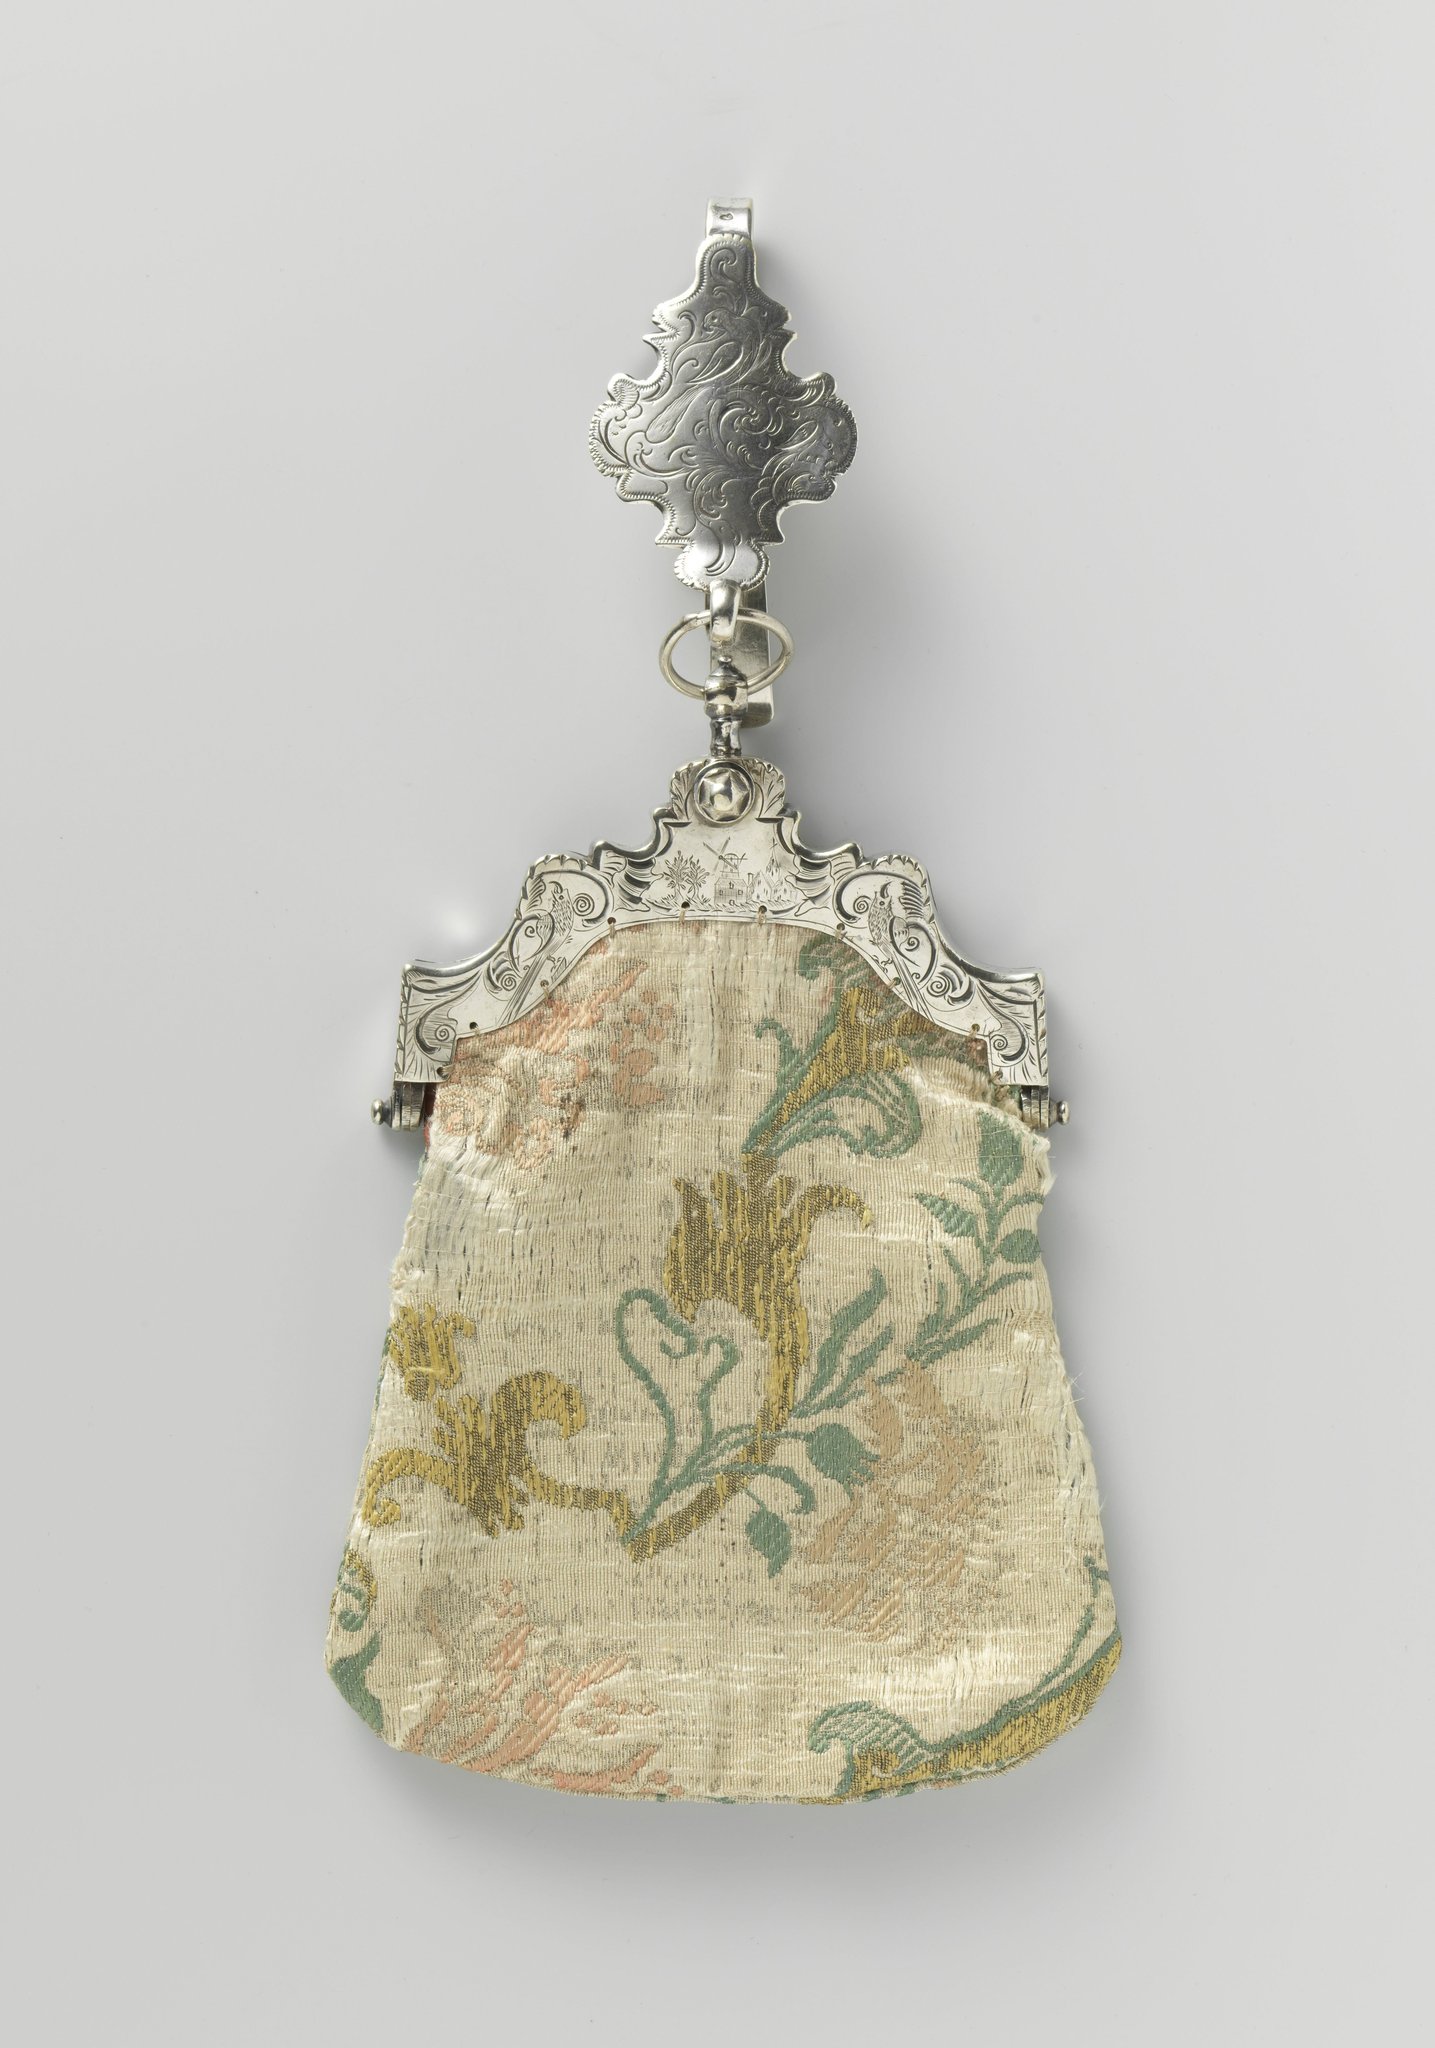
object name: beugeltas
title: Beugeltas van zilver en zijden brokaat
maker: Anonymous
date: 1789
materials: silver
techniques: brocade, forging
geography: rotterdam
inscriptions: maker's mark: ‘I.V.I’, date letter: ‘G’, coat of arms, silver mark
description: Beugeltas van zilver en zijden brokaat. Hooggewelfde symmetrisch geschulpte beugel met grove gravering van een landschapje met molen en papegaaien. Zware rokhaak met een platte, geschulpte cartouche met papegaaien. Zilvermerken: dolfijn (=belastingstempel 1859-1893), G (jaarletter 1789) wapen (Rotterdam) en I.V.I. (=ongeidentificeerd meesterteken). Tas van zijdenbrokaat in zakmodel, met losse bloemtakken in grijs, goud, rose en aubergine op een creme en zilveren fond.